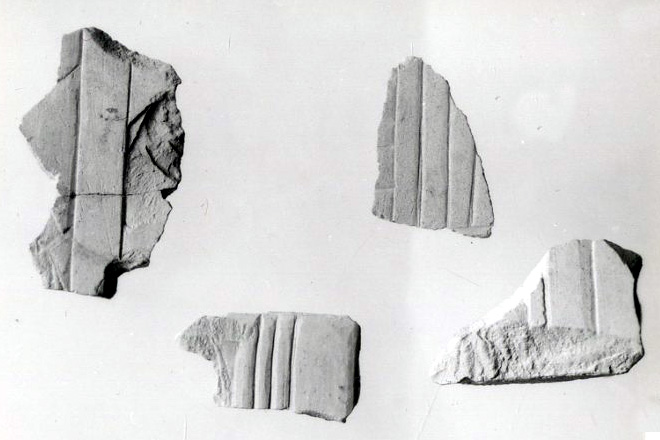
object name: relief fragment, tomb of meketre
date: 1981-1975 BCE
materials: limestone, paint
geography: egypt